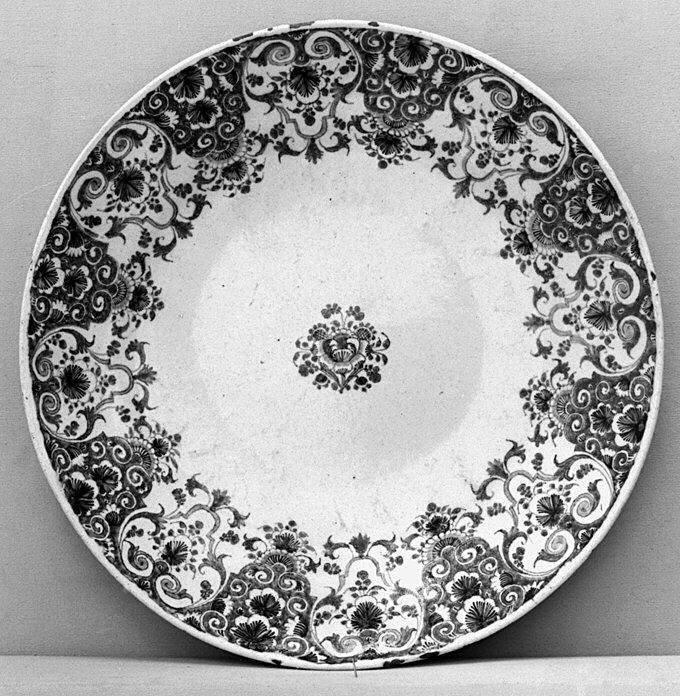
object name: plate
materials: faience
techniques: glazing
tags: flowers